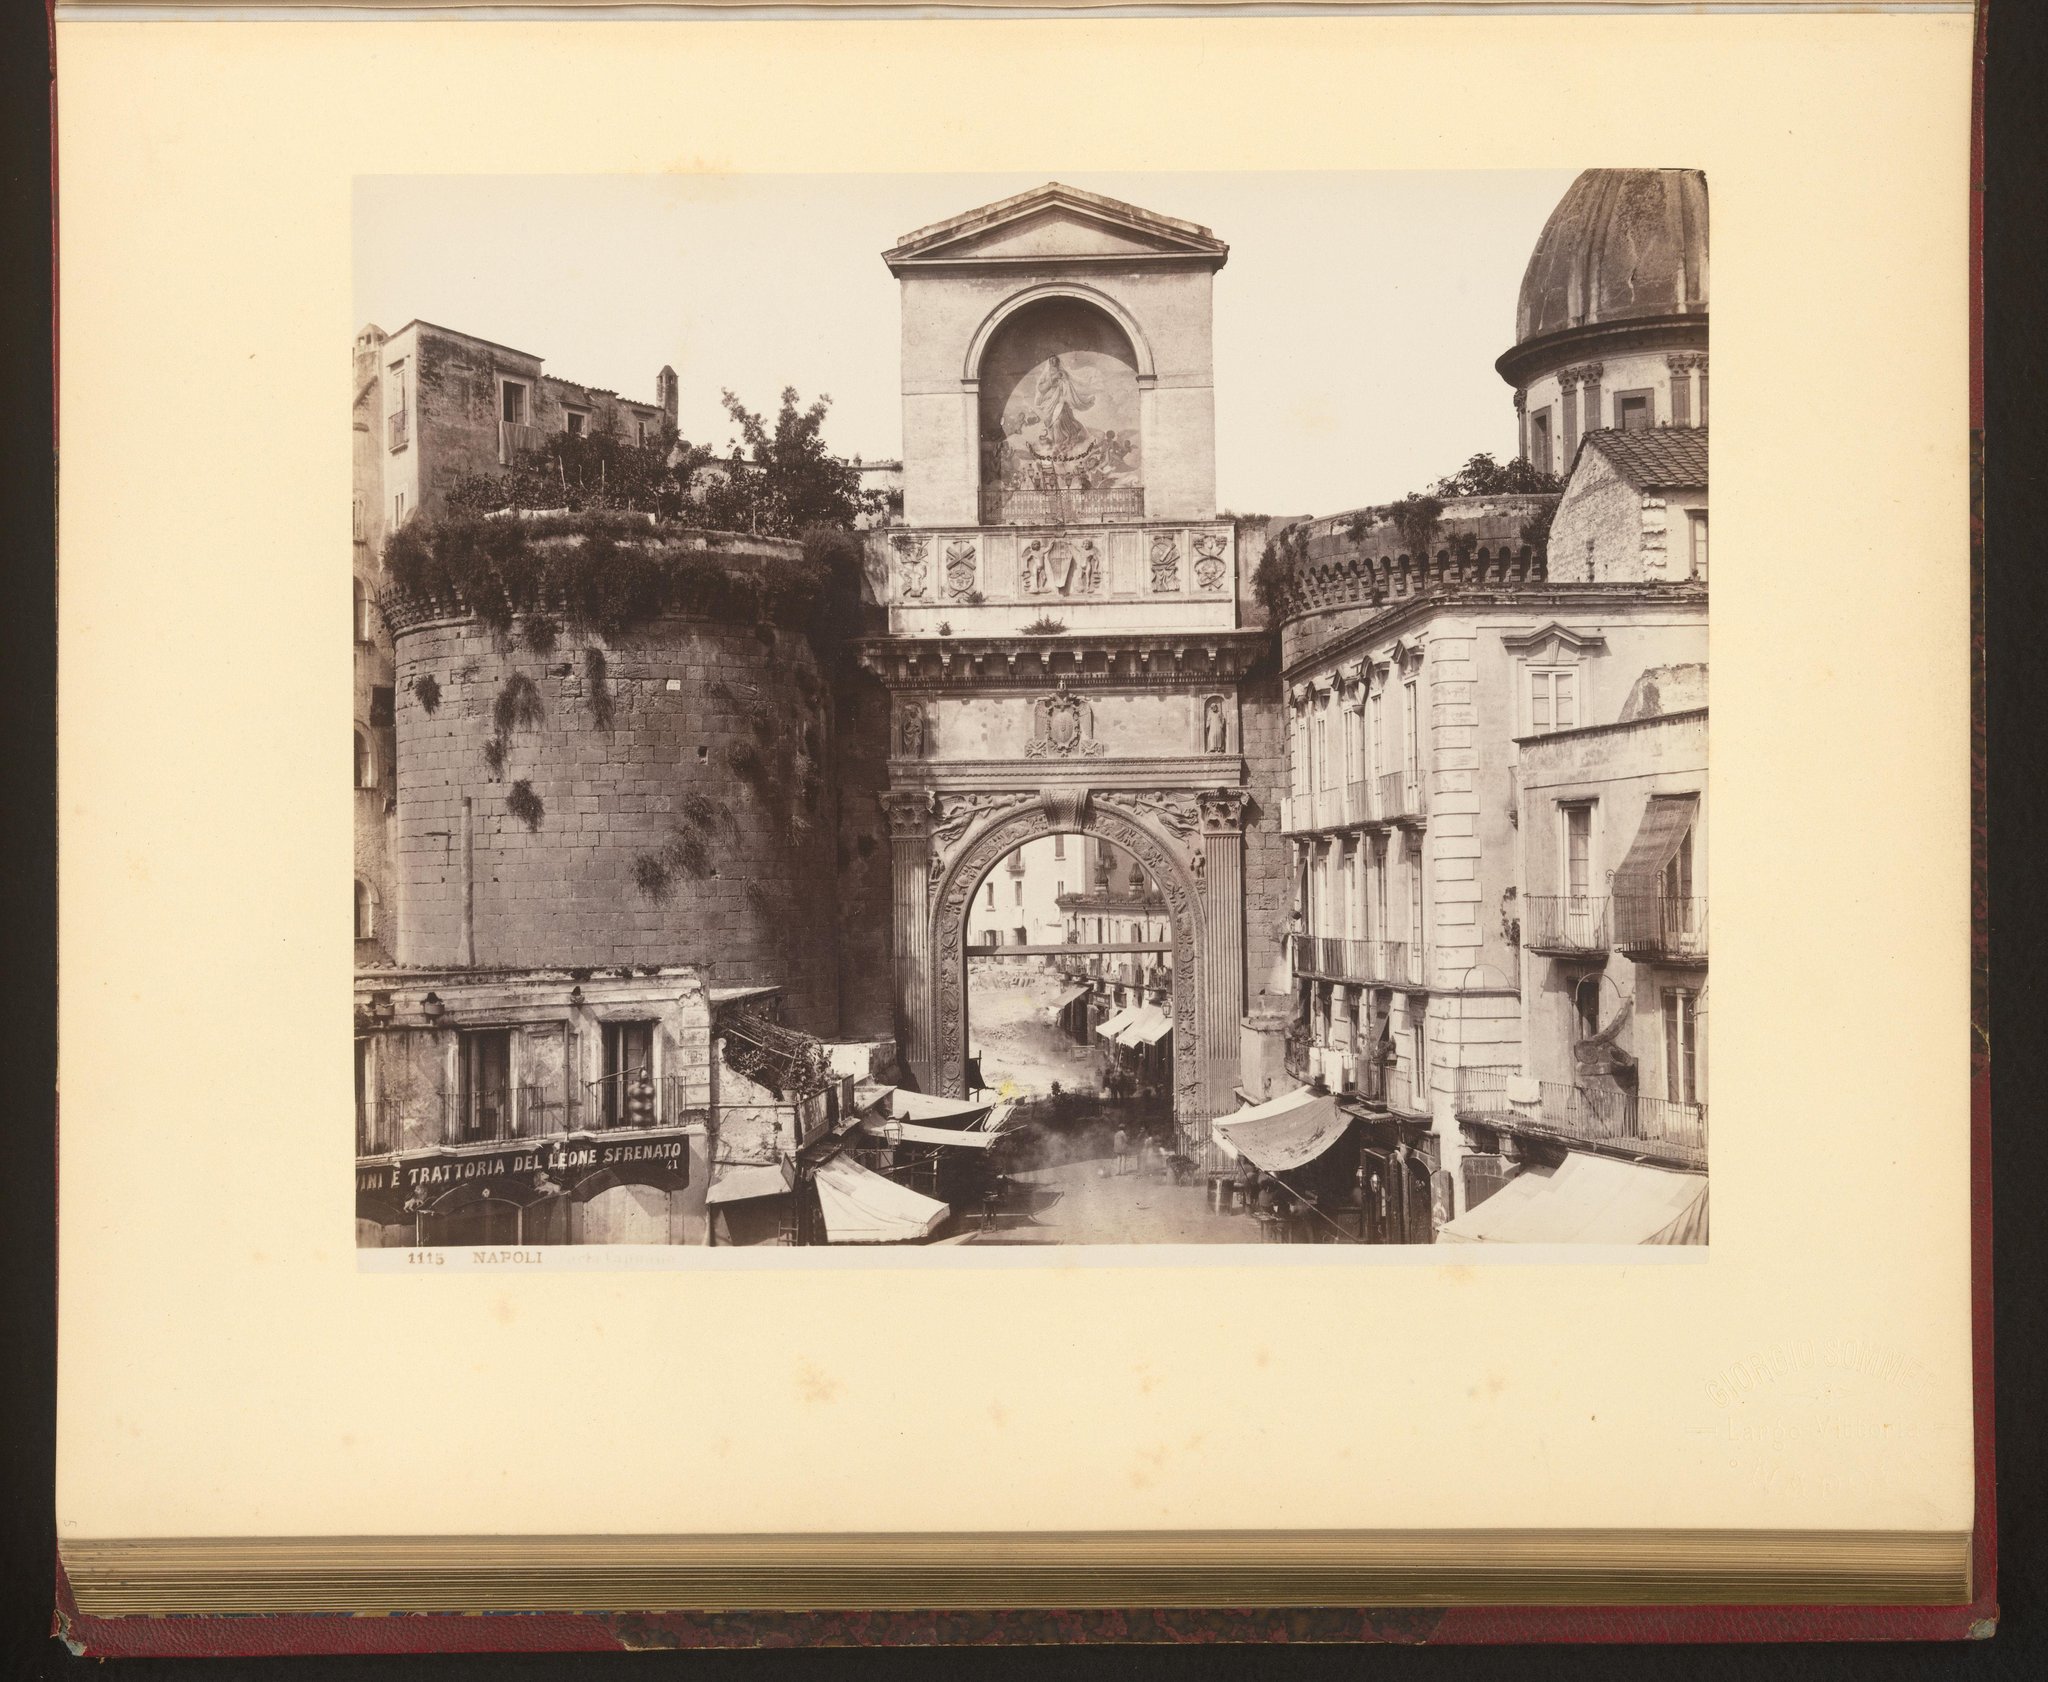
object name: photograph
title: Porta Capuana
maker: giorgio sommer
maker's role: fotograaf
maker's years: 1834-1914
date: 1874-1879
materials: photographic support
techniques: albumen print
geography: naples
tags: gate ~ fortified city, naples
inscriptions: number: ‘1115’, workshop stamp: ‘Giorgio Sommer/ Largo Vittoria/ Napoli’